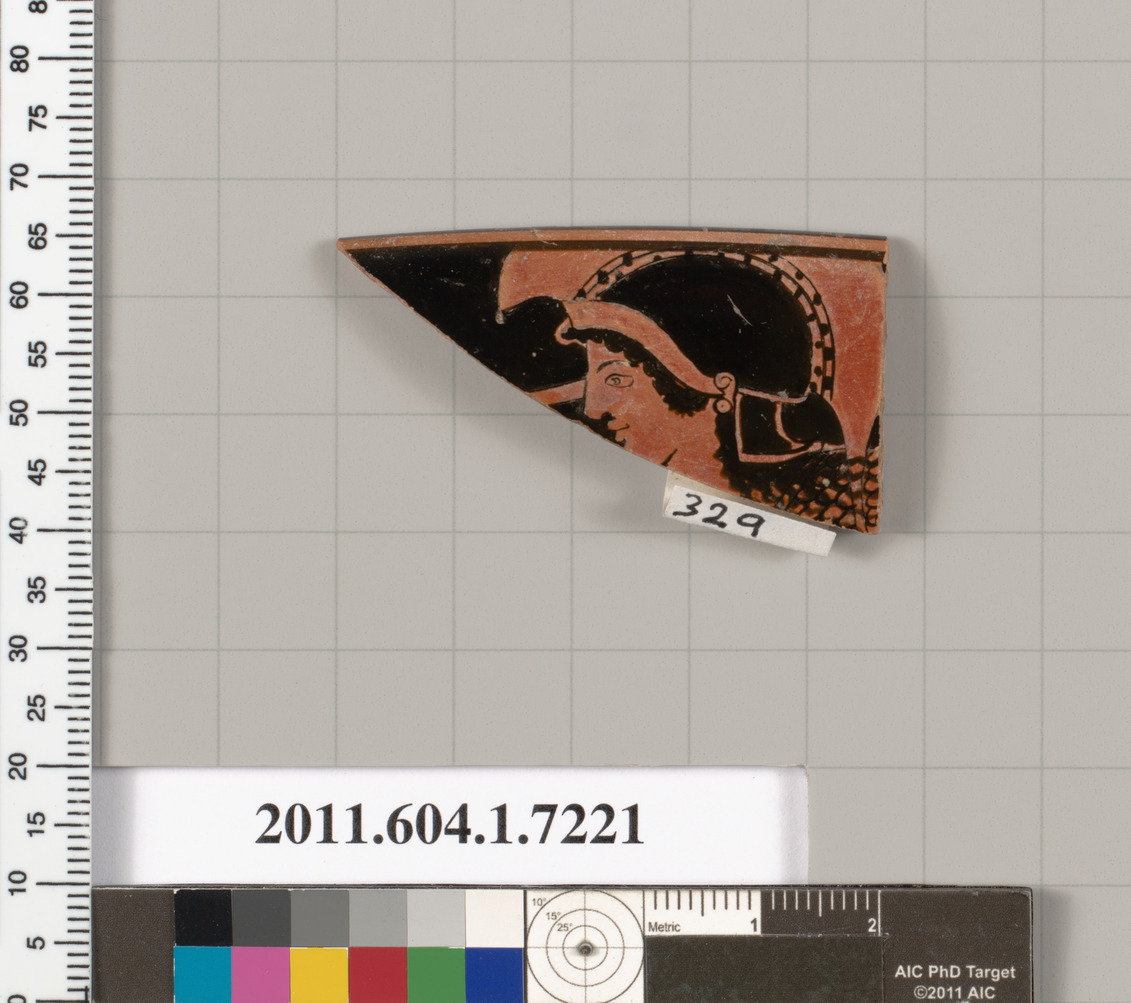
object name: kylix fragment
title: Terracotta rim fragment of a kylix (drinking cup)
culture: greek, attic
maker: makron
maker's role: artist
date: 500-480 BCE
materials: terracotta